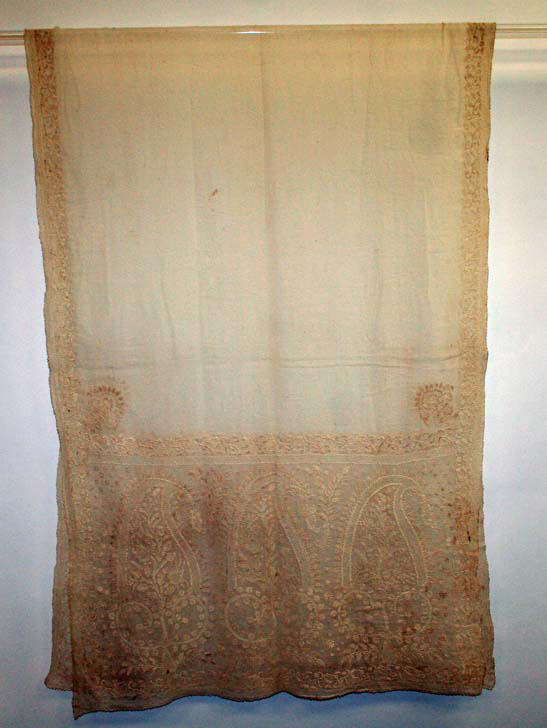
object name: shawl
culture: american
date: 1800-1810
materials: cotton